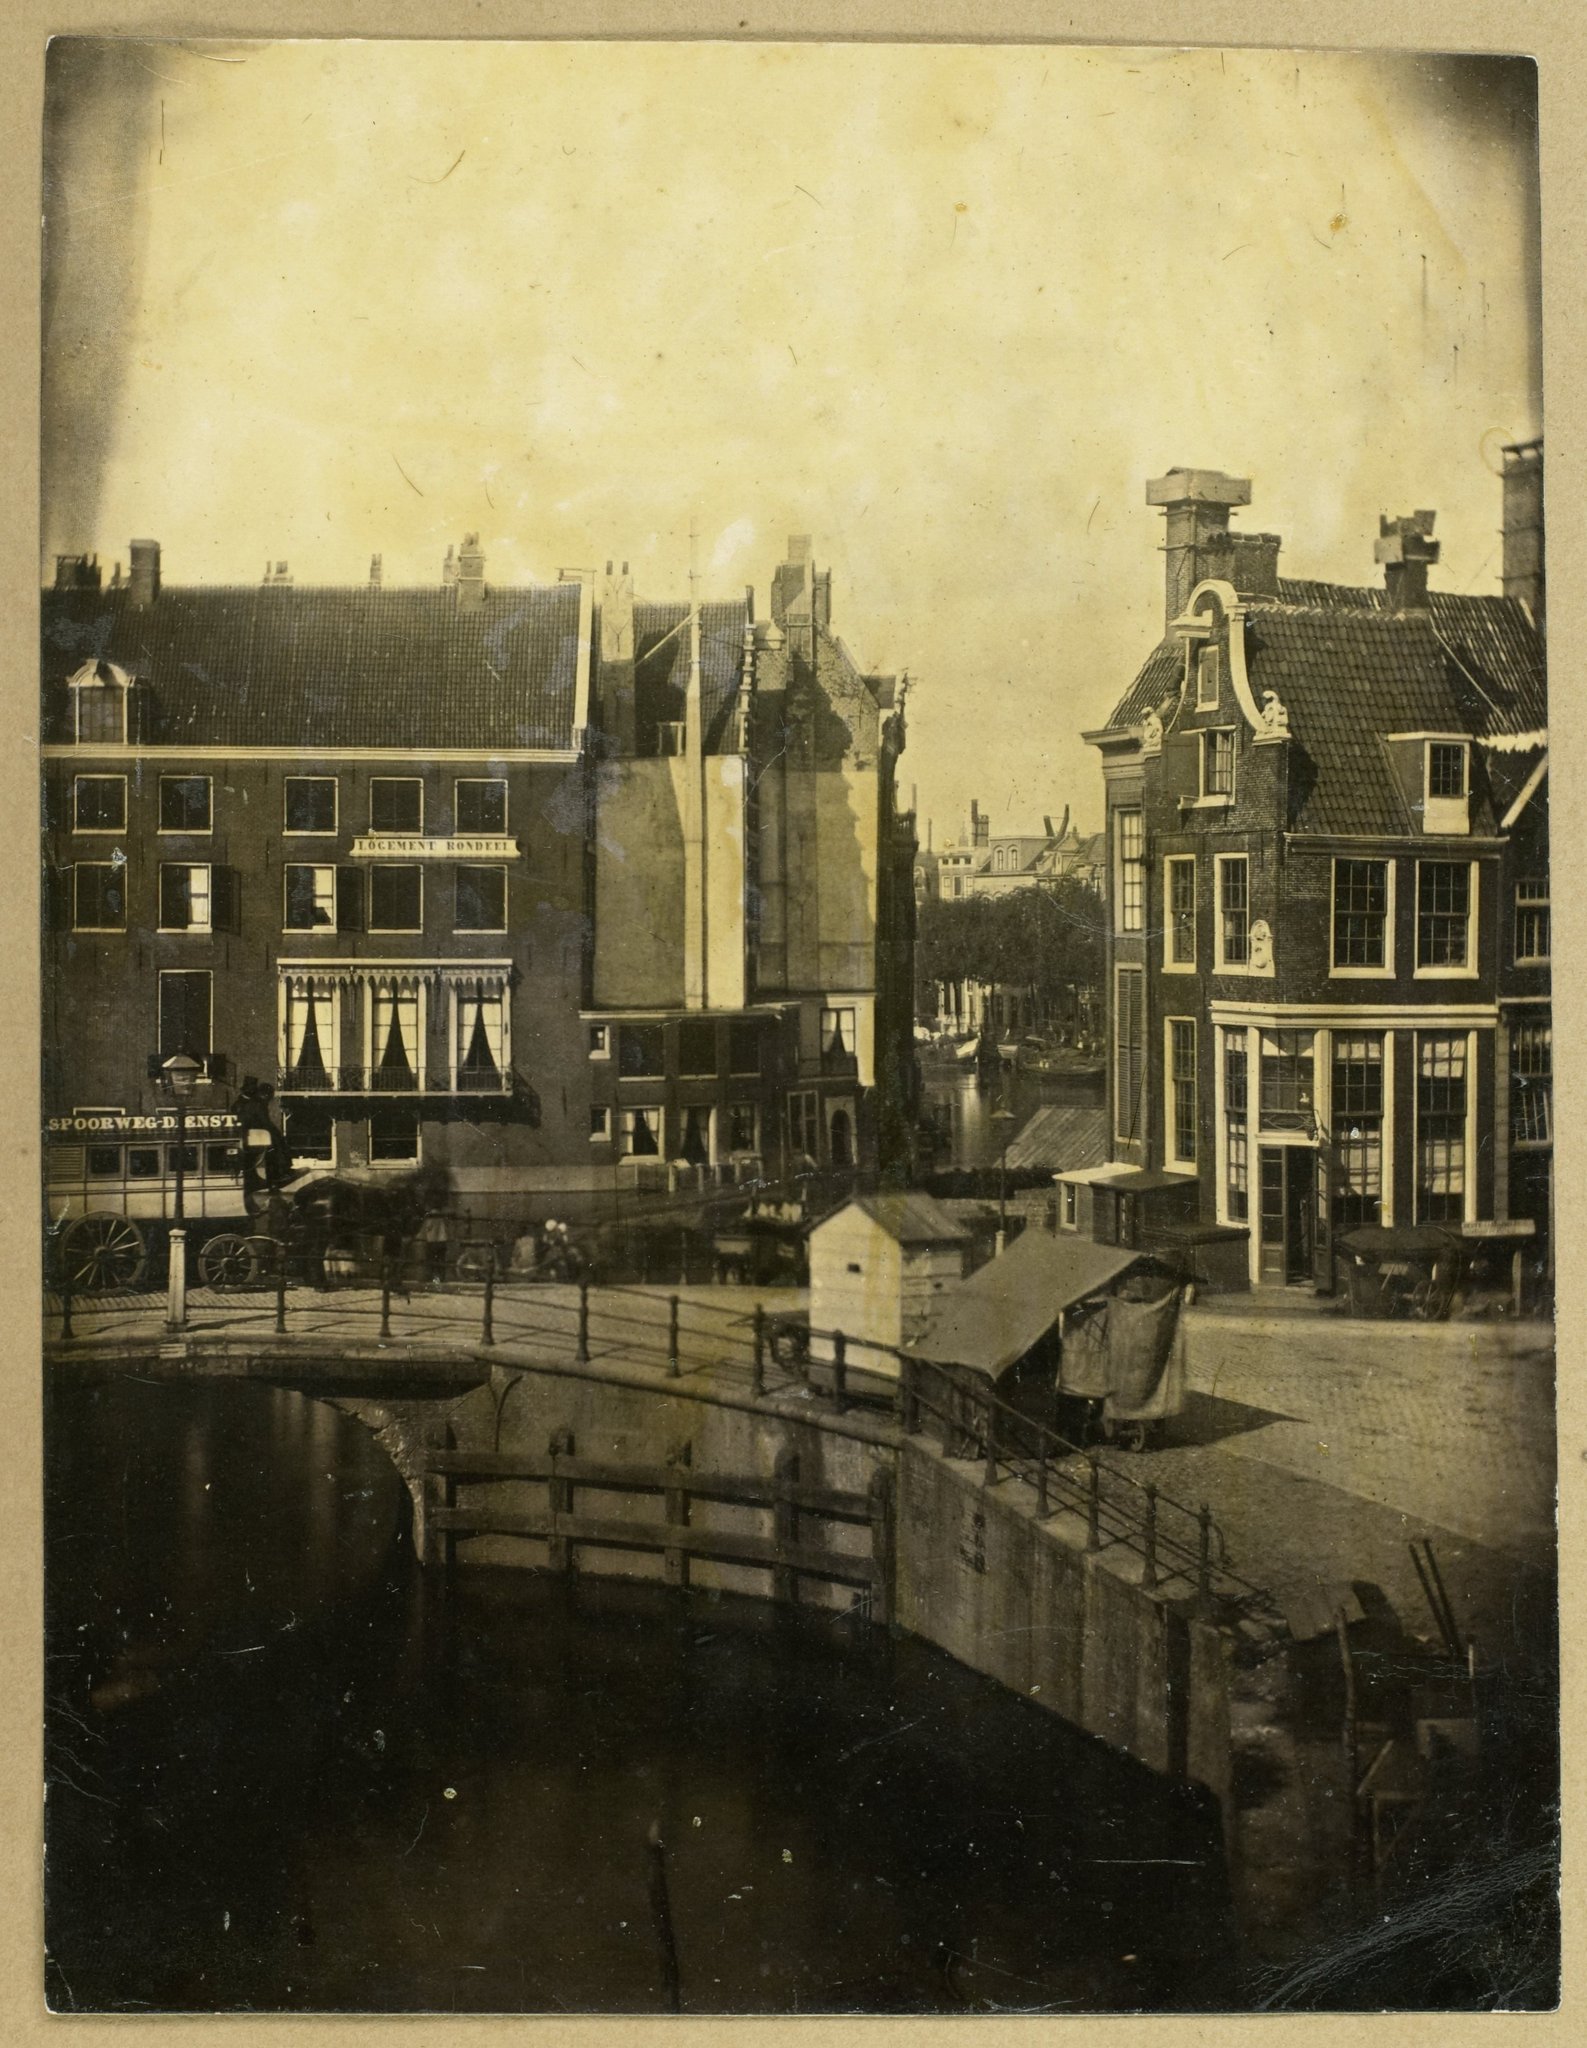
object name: photograph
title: Gezicht op logement Rondeel in Amsterdam vanuit het huis van de fotograaf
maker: eduard isaac asser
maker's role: amateurfotograaf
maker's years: 1809-1894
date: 1853-1855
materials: cardboard, paper, photographic support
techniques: salted paper print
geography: amsterdam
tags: hotel het rondeel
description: Uitzicht uit het huis van de fotograaf, Singel 548, over de Muntsluis, naar Logement Rondeel met rechts de ingang van de Reguliersbreestraat en het hoekhuis nummer 1 en links daarvan het aangrenzende Amstel 2. Rechts van de zijgevel van het hotel is een gedeelte van de achterzijde van de aangrenzende huizen in de Nieuwe Doelenstraat te zien. Op de Muntsluis staat een omnibus van de Spoorweg Dienst.